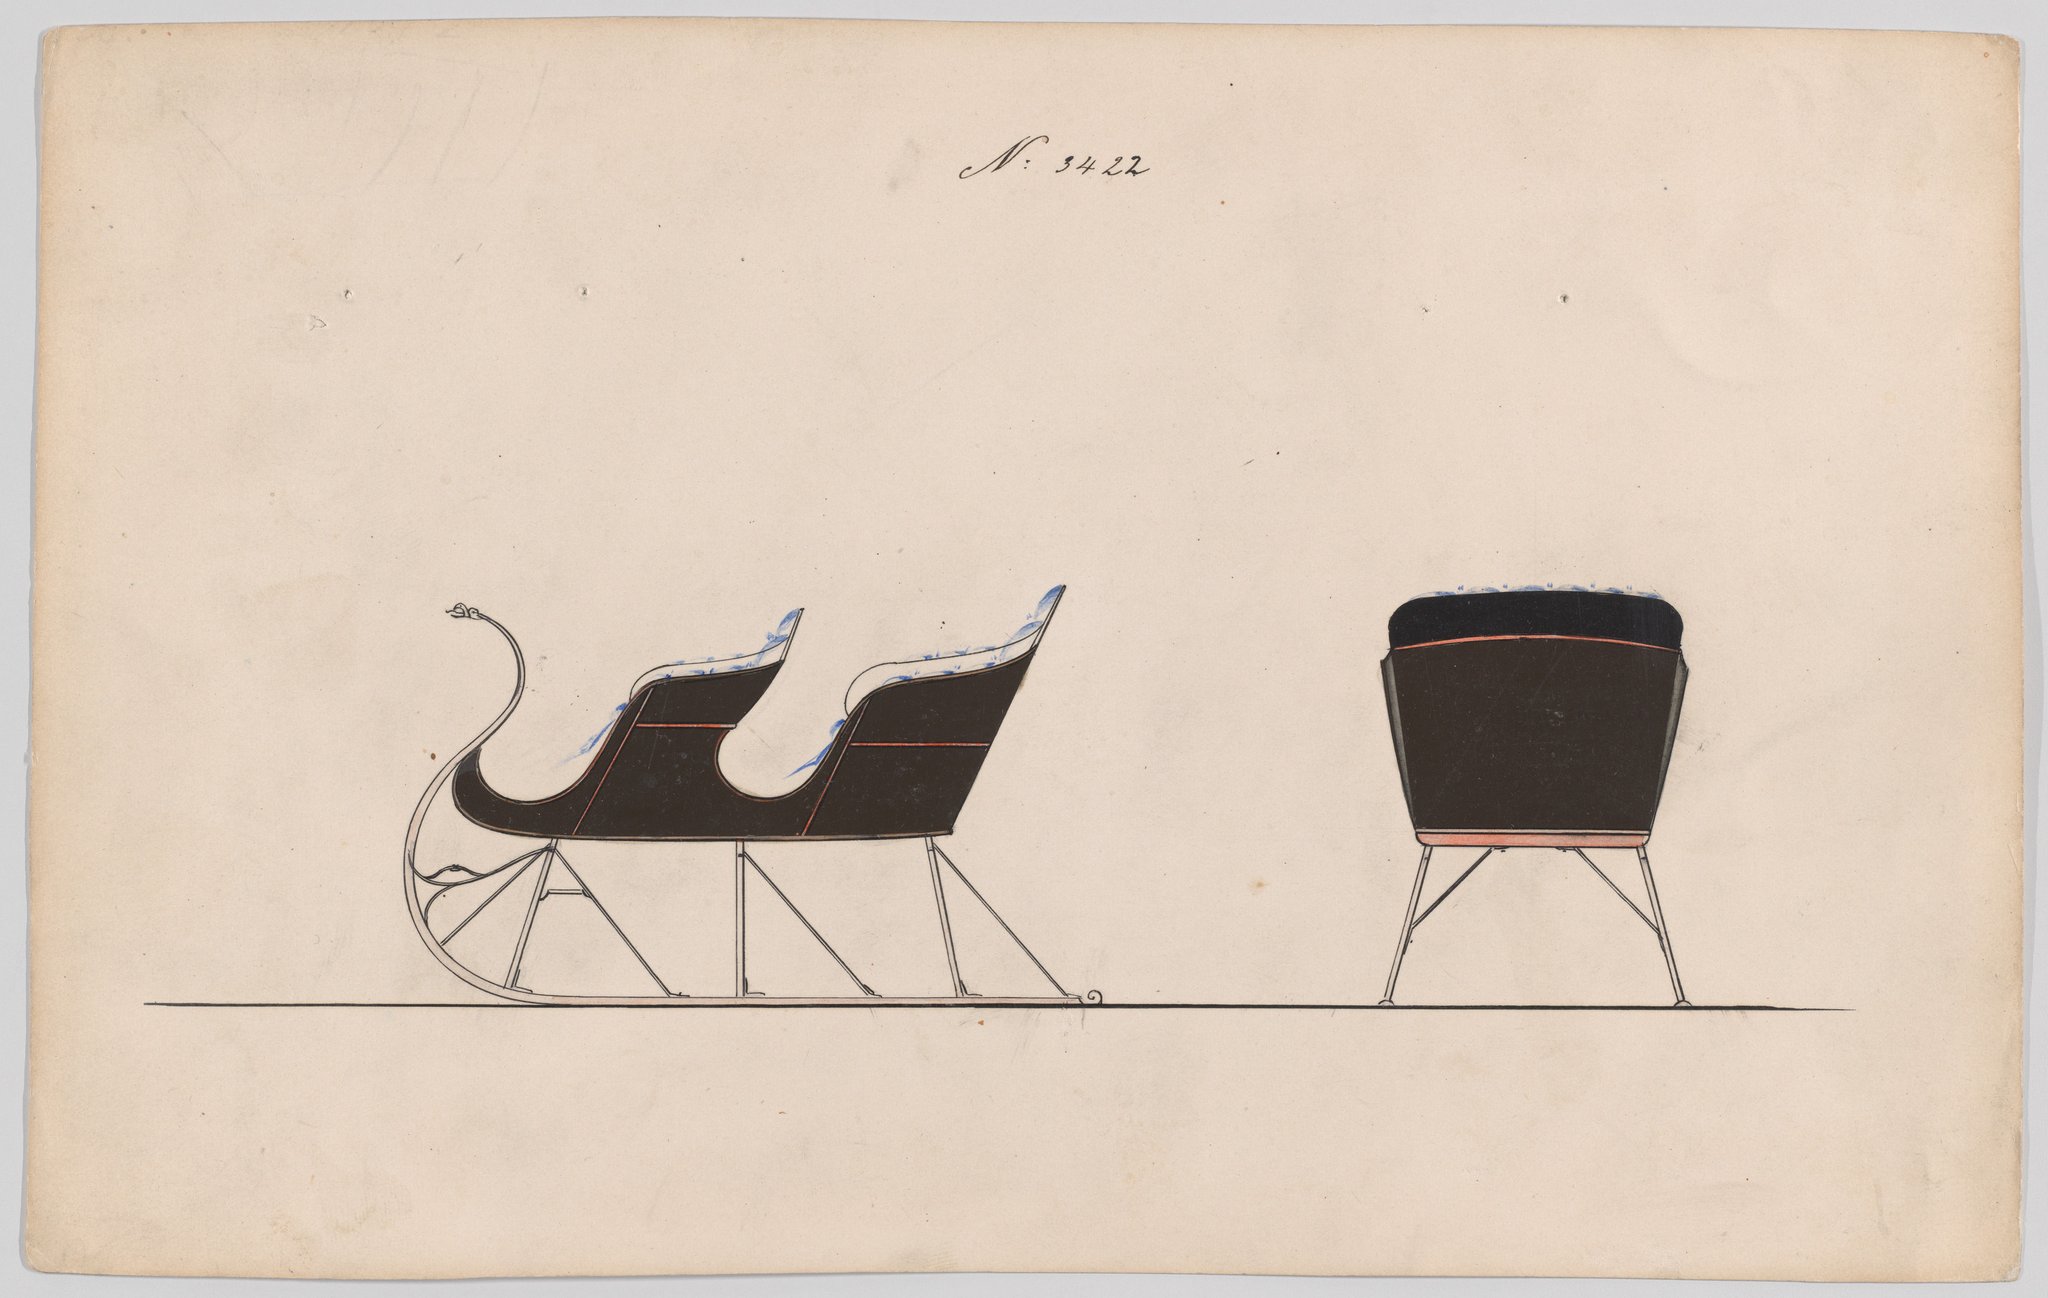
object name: drawing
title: Design for 4 Seat Sleigh, no. 3422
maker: brewster & co.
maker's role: manufacturer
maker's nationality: american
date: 1878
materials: gouache, gum arabic, watercolor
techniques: pen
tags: sleighs